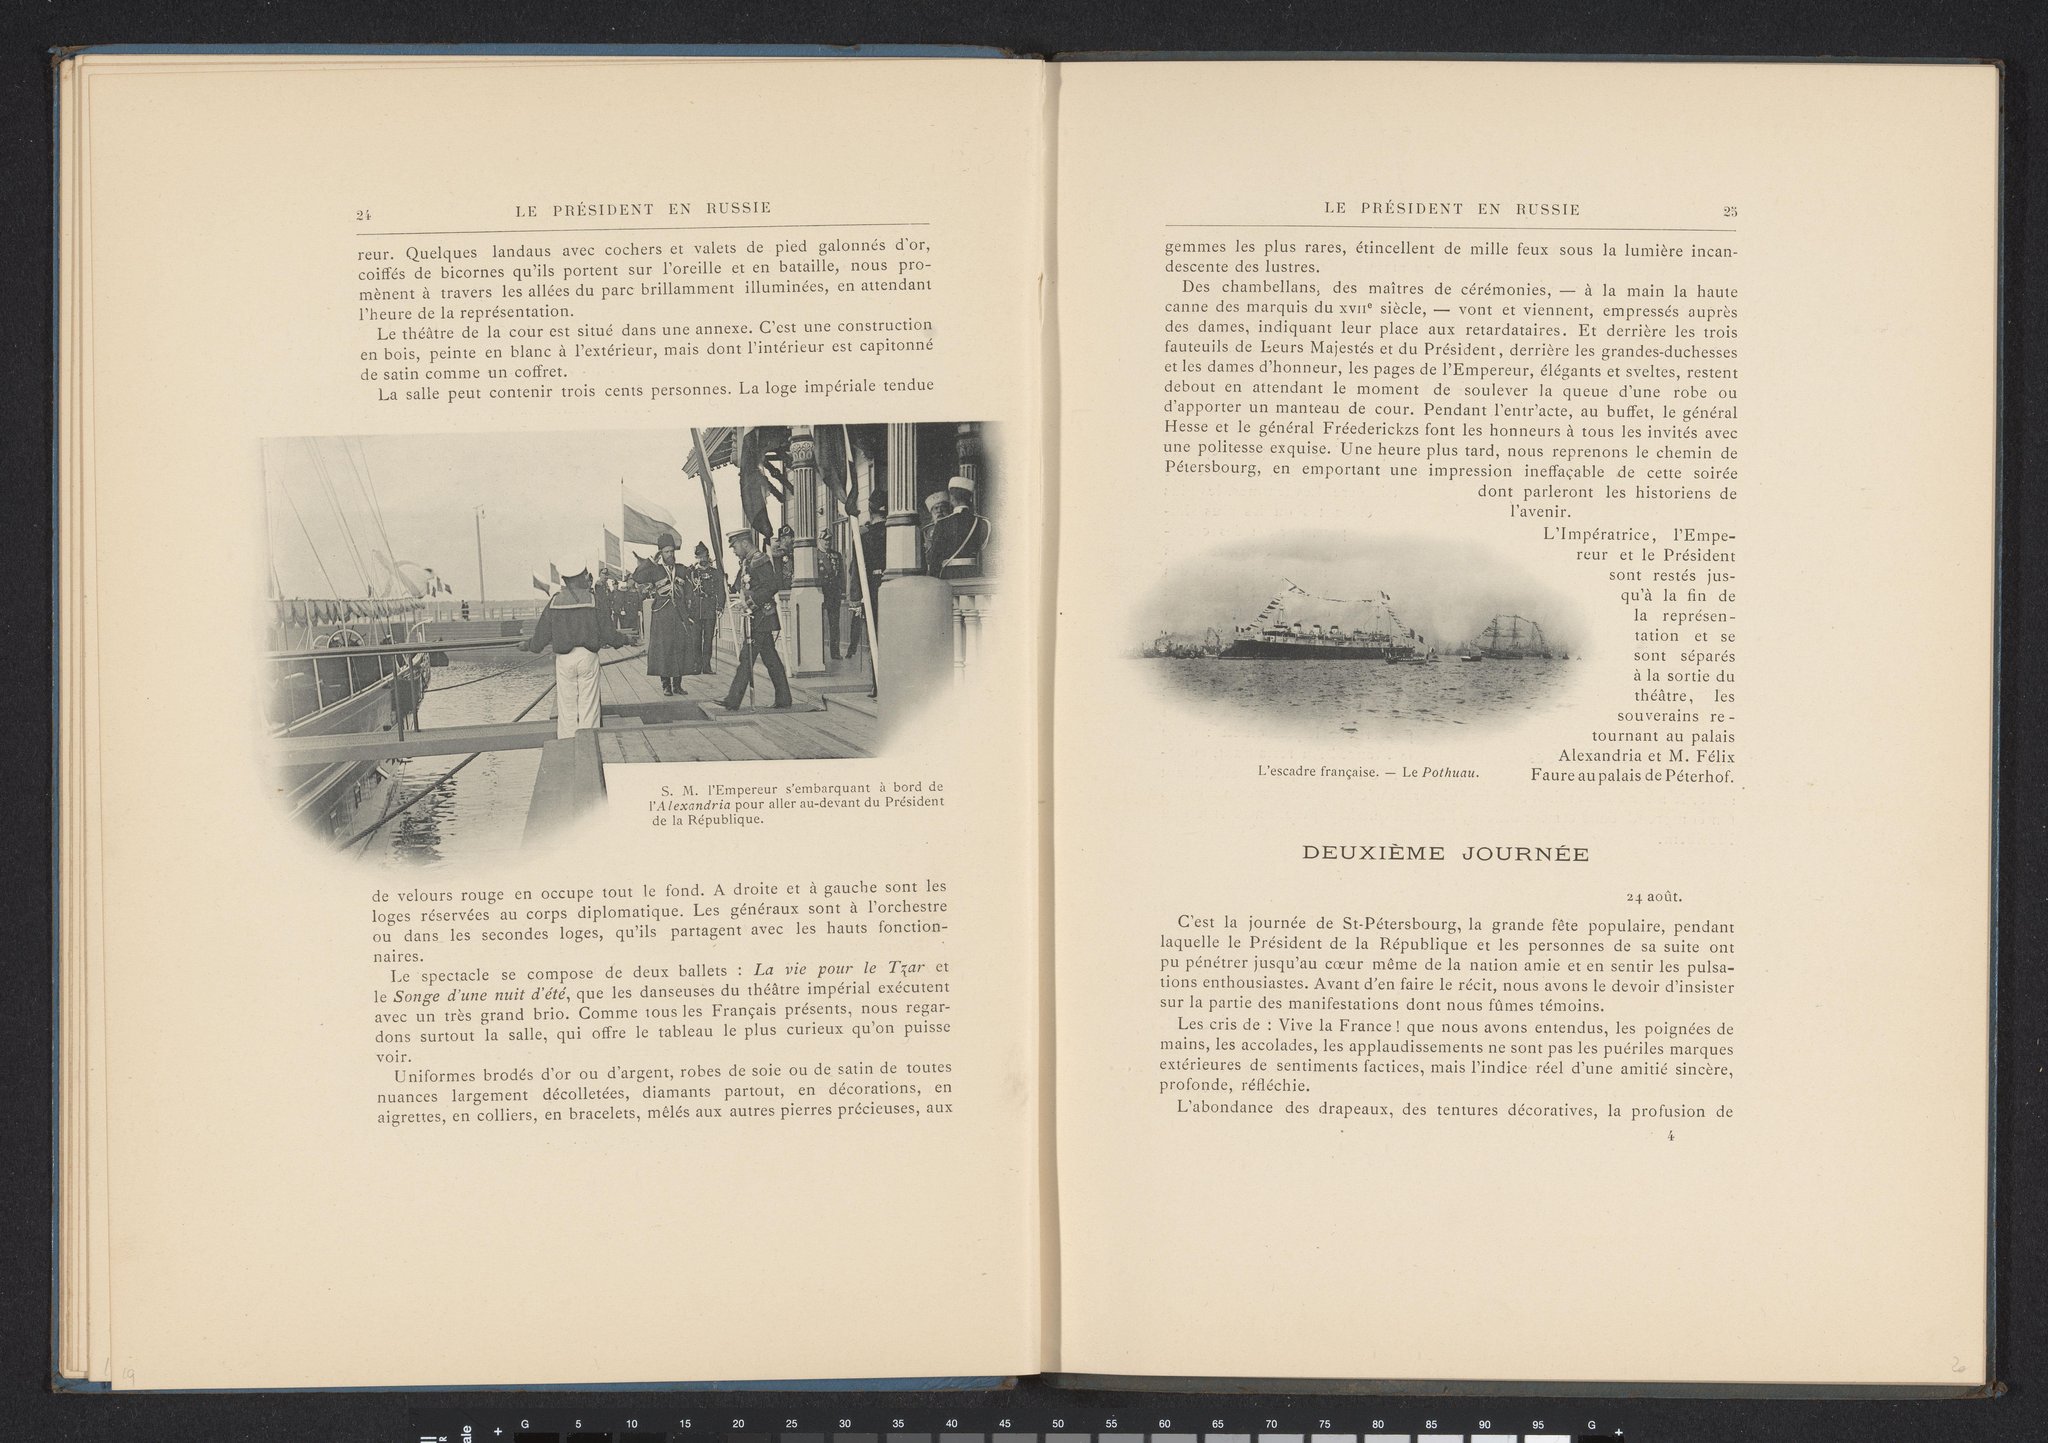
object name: photomechanical print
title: Gezicht op de Franse kruiser Pothuau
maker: Anonymous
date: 1897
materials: paper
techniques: photograph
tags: steamship, motorship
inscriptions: inscription: ‘L'escadre française.- Le Pothuau’